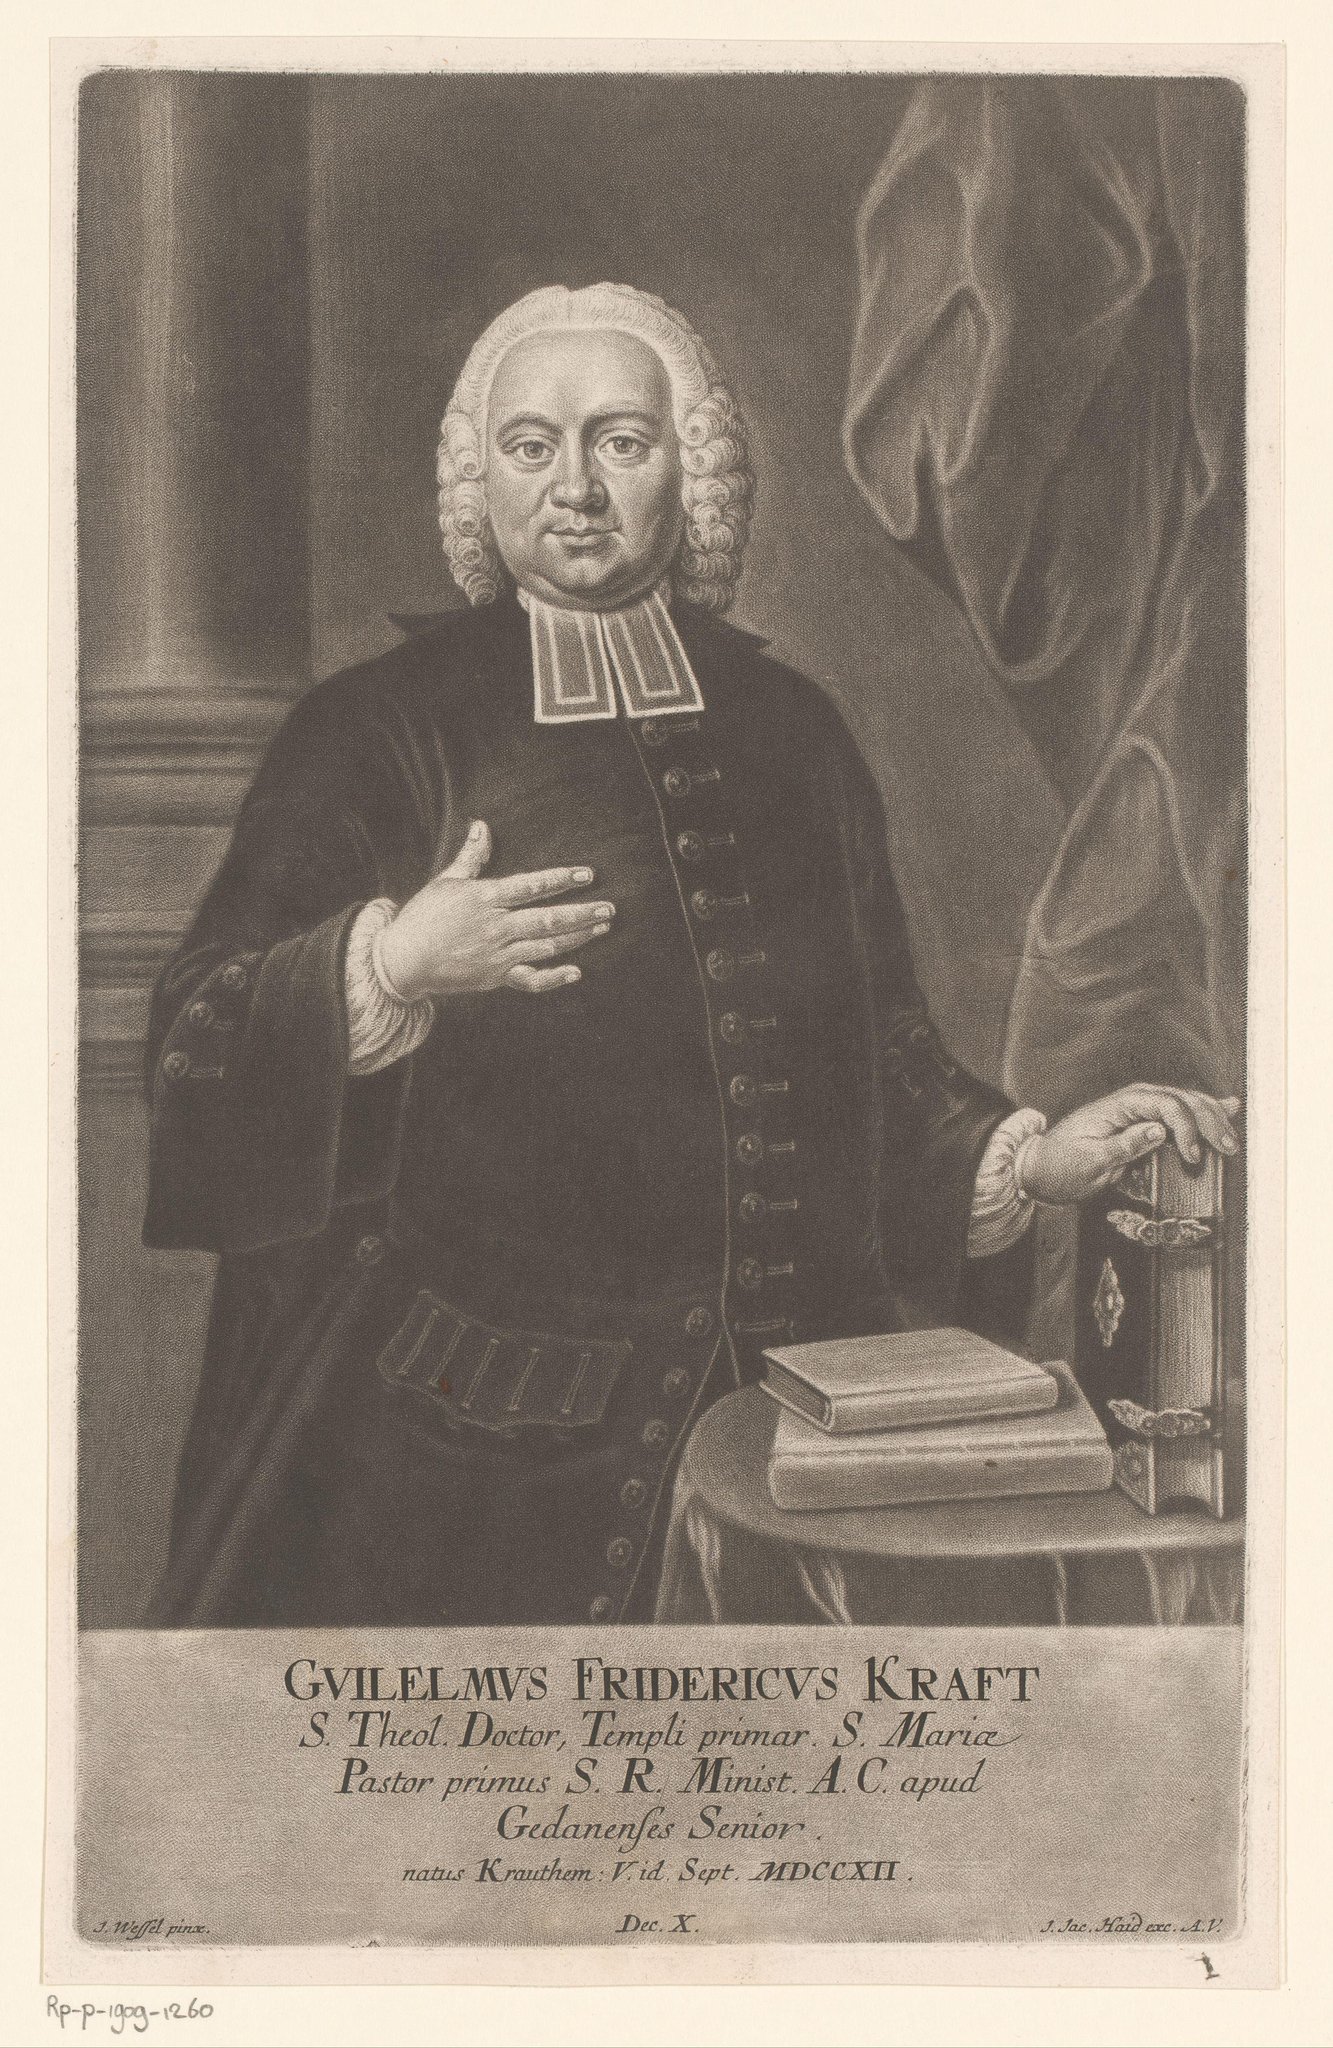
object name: print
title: Portret van Friedrich Wilhelm Kraft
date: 1755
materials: paper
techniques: mezzotint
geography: augsburg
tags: theologian, historical persons, book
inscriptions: collector's mark: Lugt 2228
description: Prent gebruikt voor: Brucker, Jacob. Bildersal heutiges Tages lebender und durch Gelahrheit berühmter Schrifftsteller. Augsburg: Johann Jacob Haid, 1755.